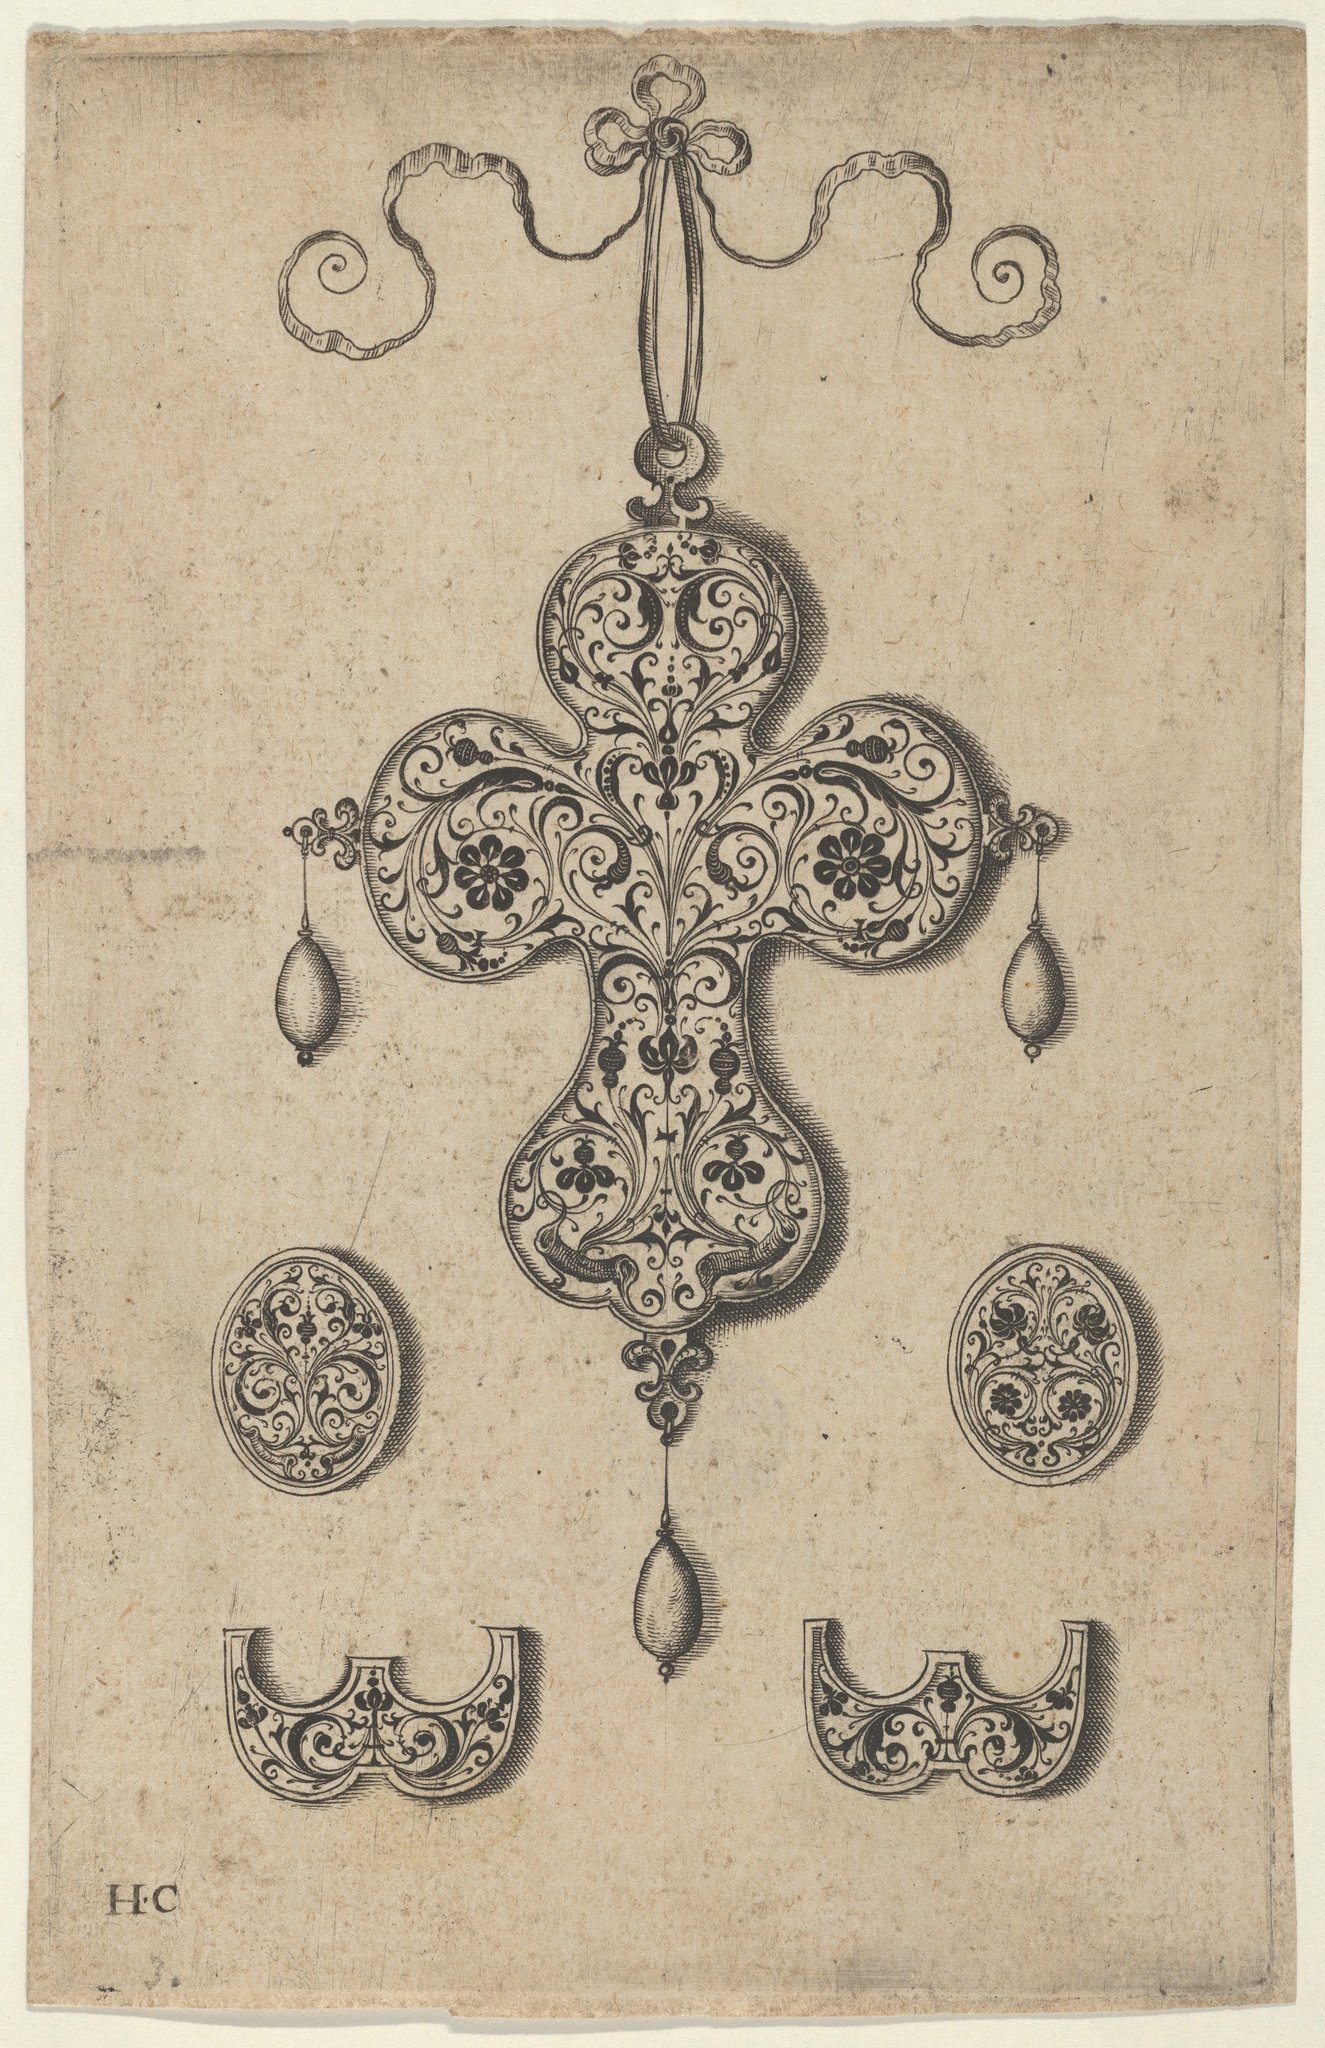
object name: print ornament architecture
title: Design for the Verso of a Cross-Shaped Pendant Above a Pair of Oval Ornaments and Axe-Shaped Ornaments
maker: jan collaert i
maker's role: artist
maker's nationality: netherlandish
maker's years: 1530-1581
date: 1573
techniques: embroidery, engraving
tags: pendants,ornament